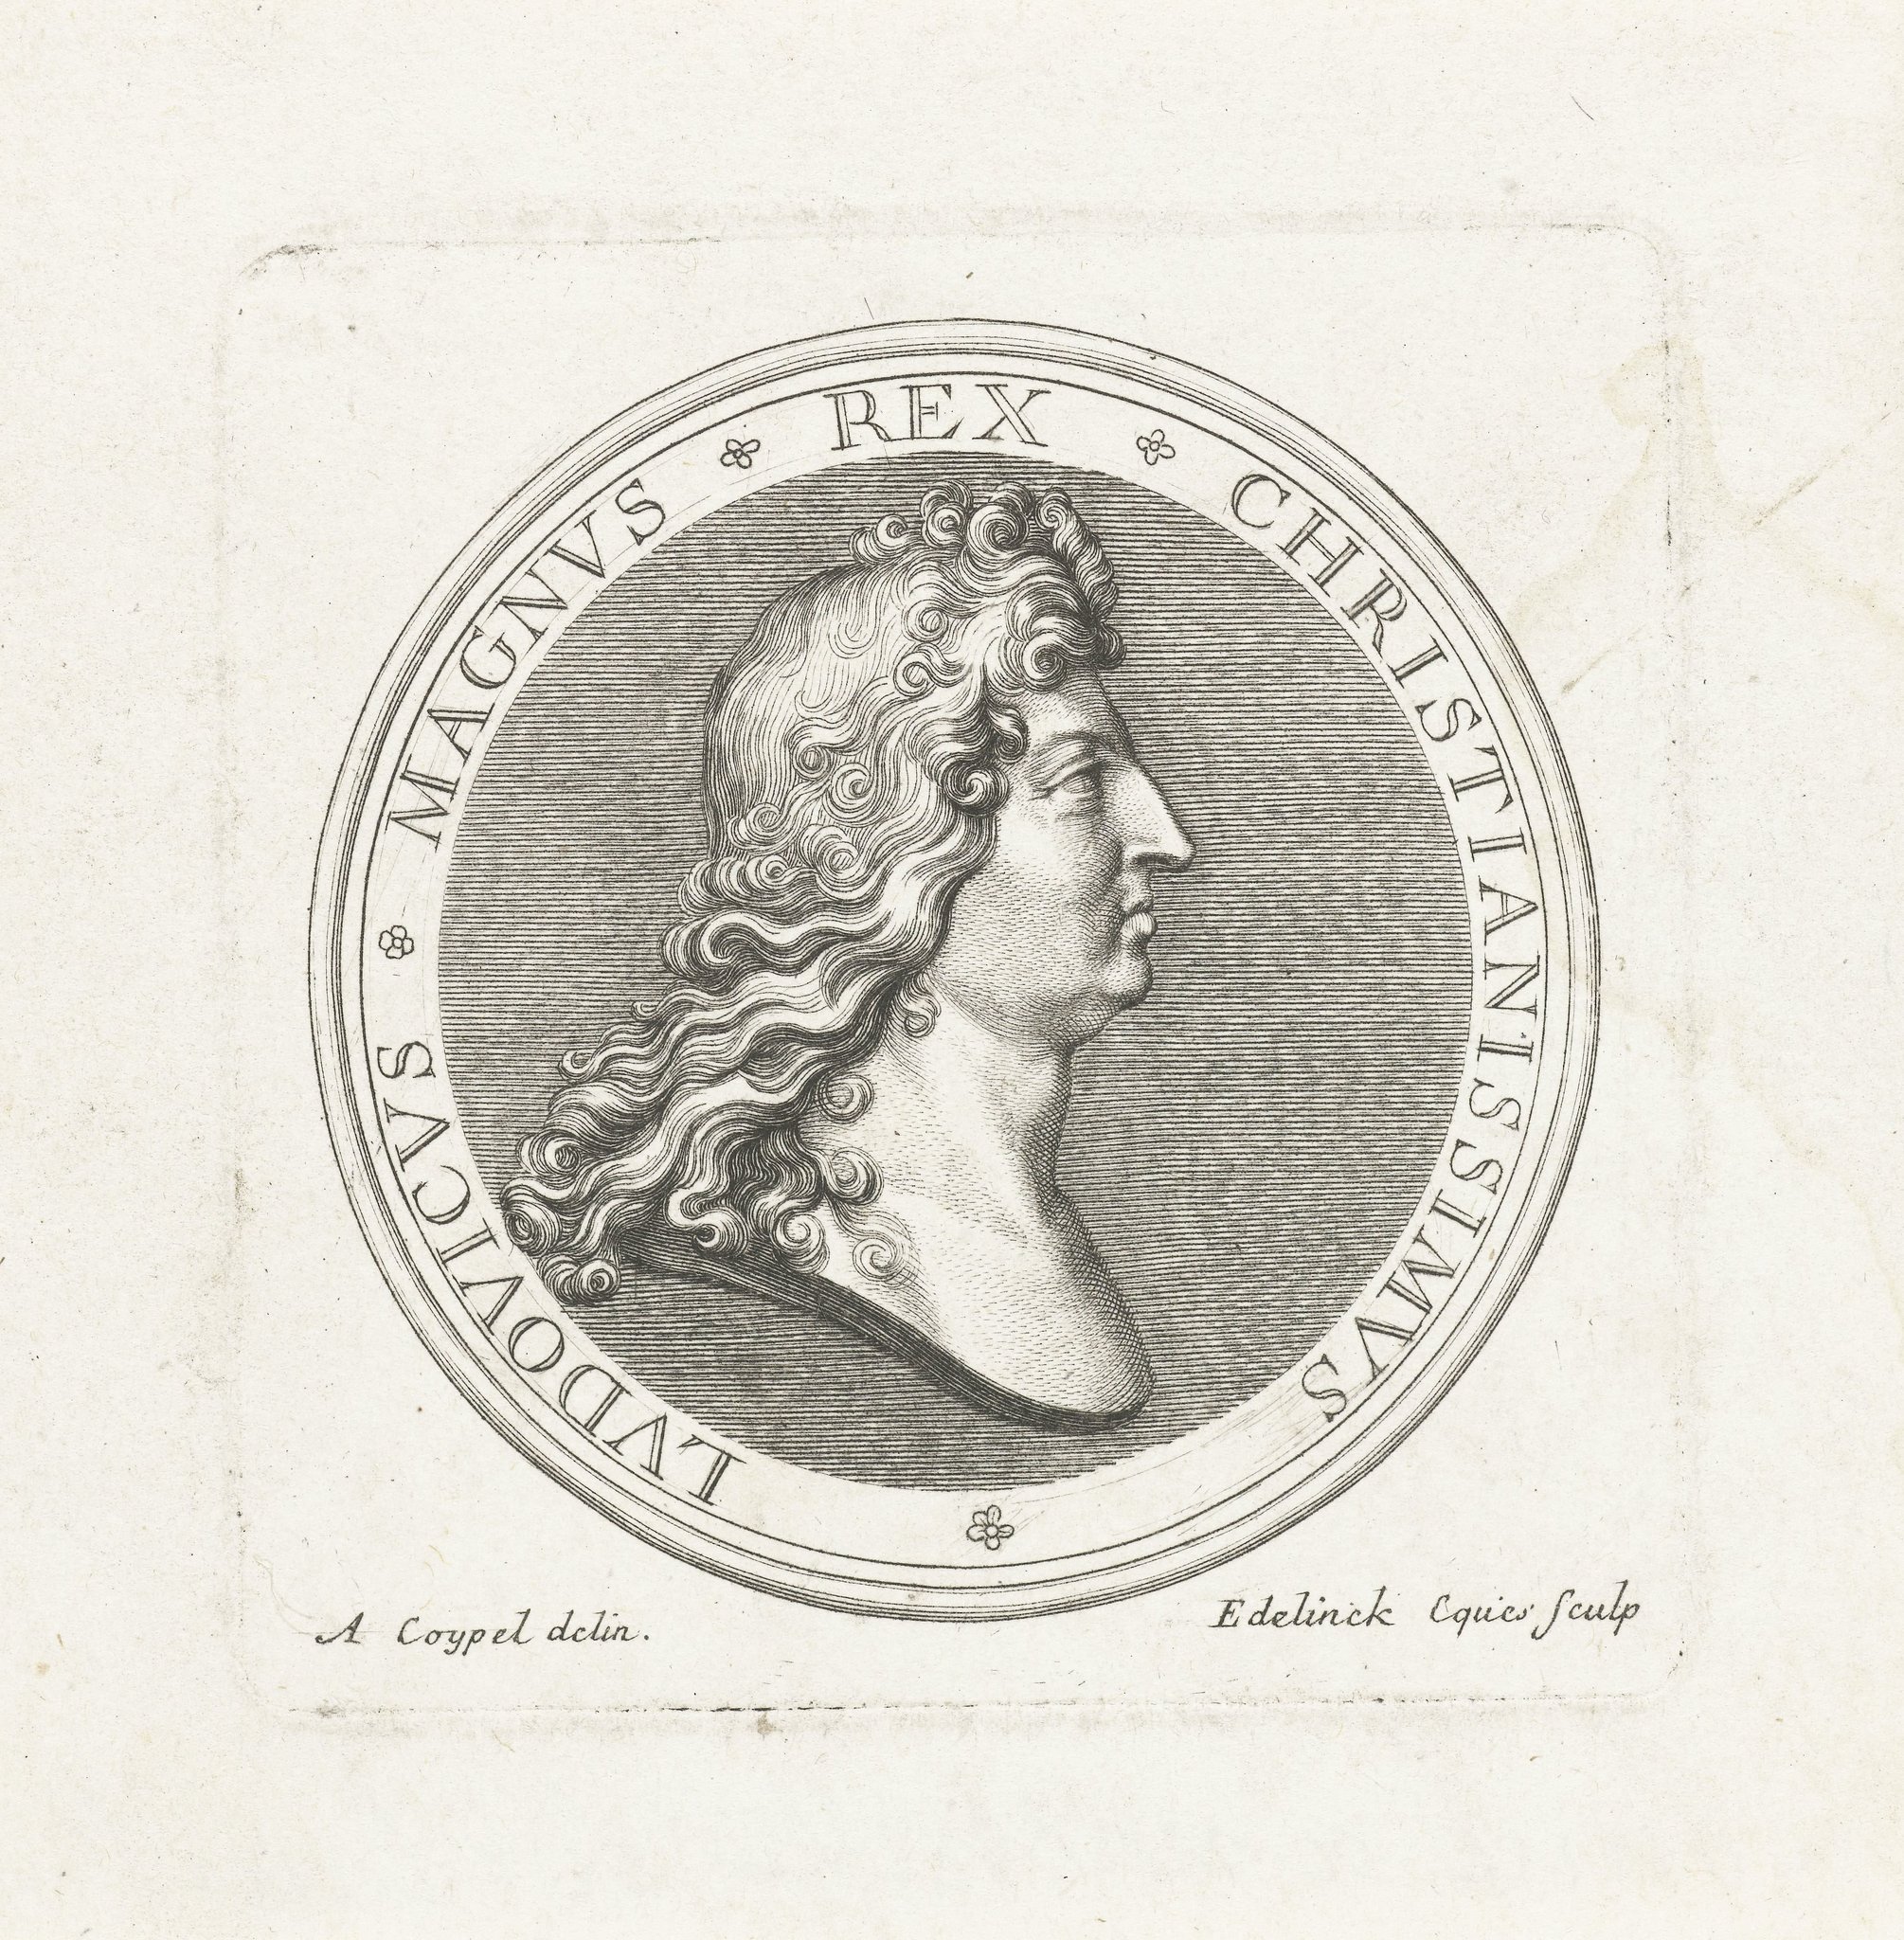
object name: print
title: Penning met buste van Lodewijk XIV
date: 1702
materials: paper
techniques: engraving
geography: paris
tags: lodewijk xiv (koning van frankrijk)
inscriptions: collector's mark: Lugt 240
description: Voorkant van een penning met buste en profil van Lodewijk XIV.